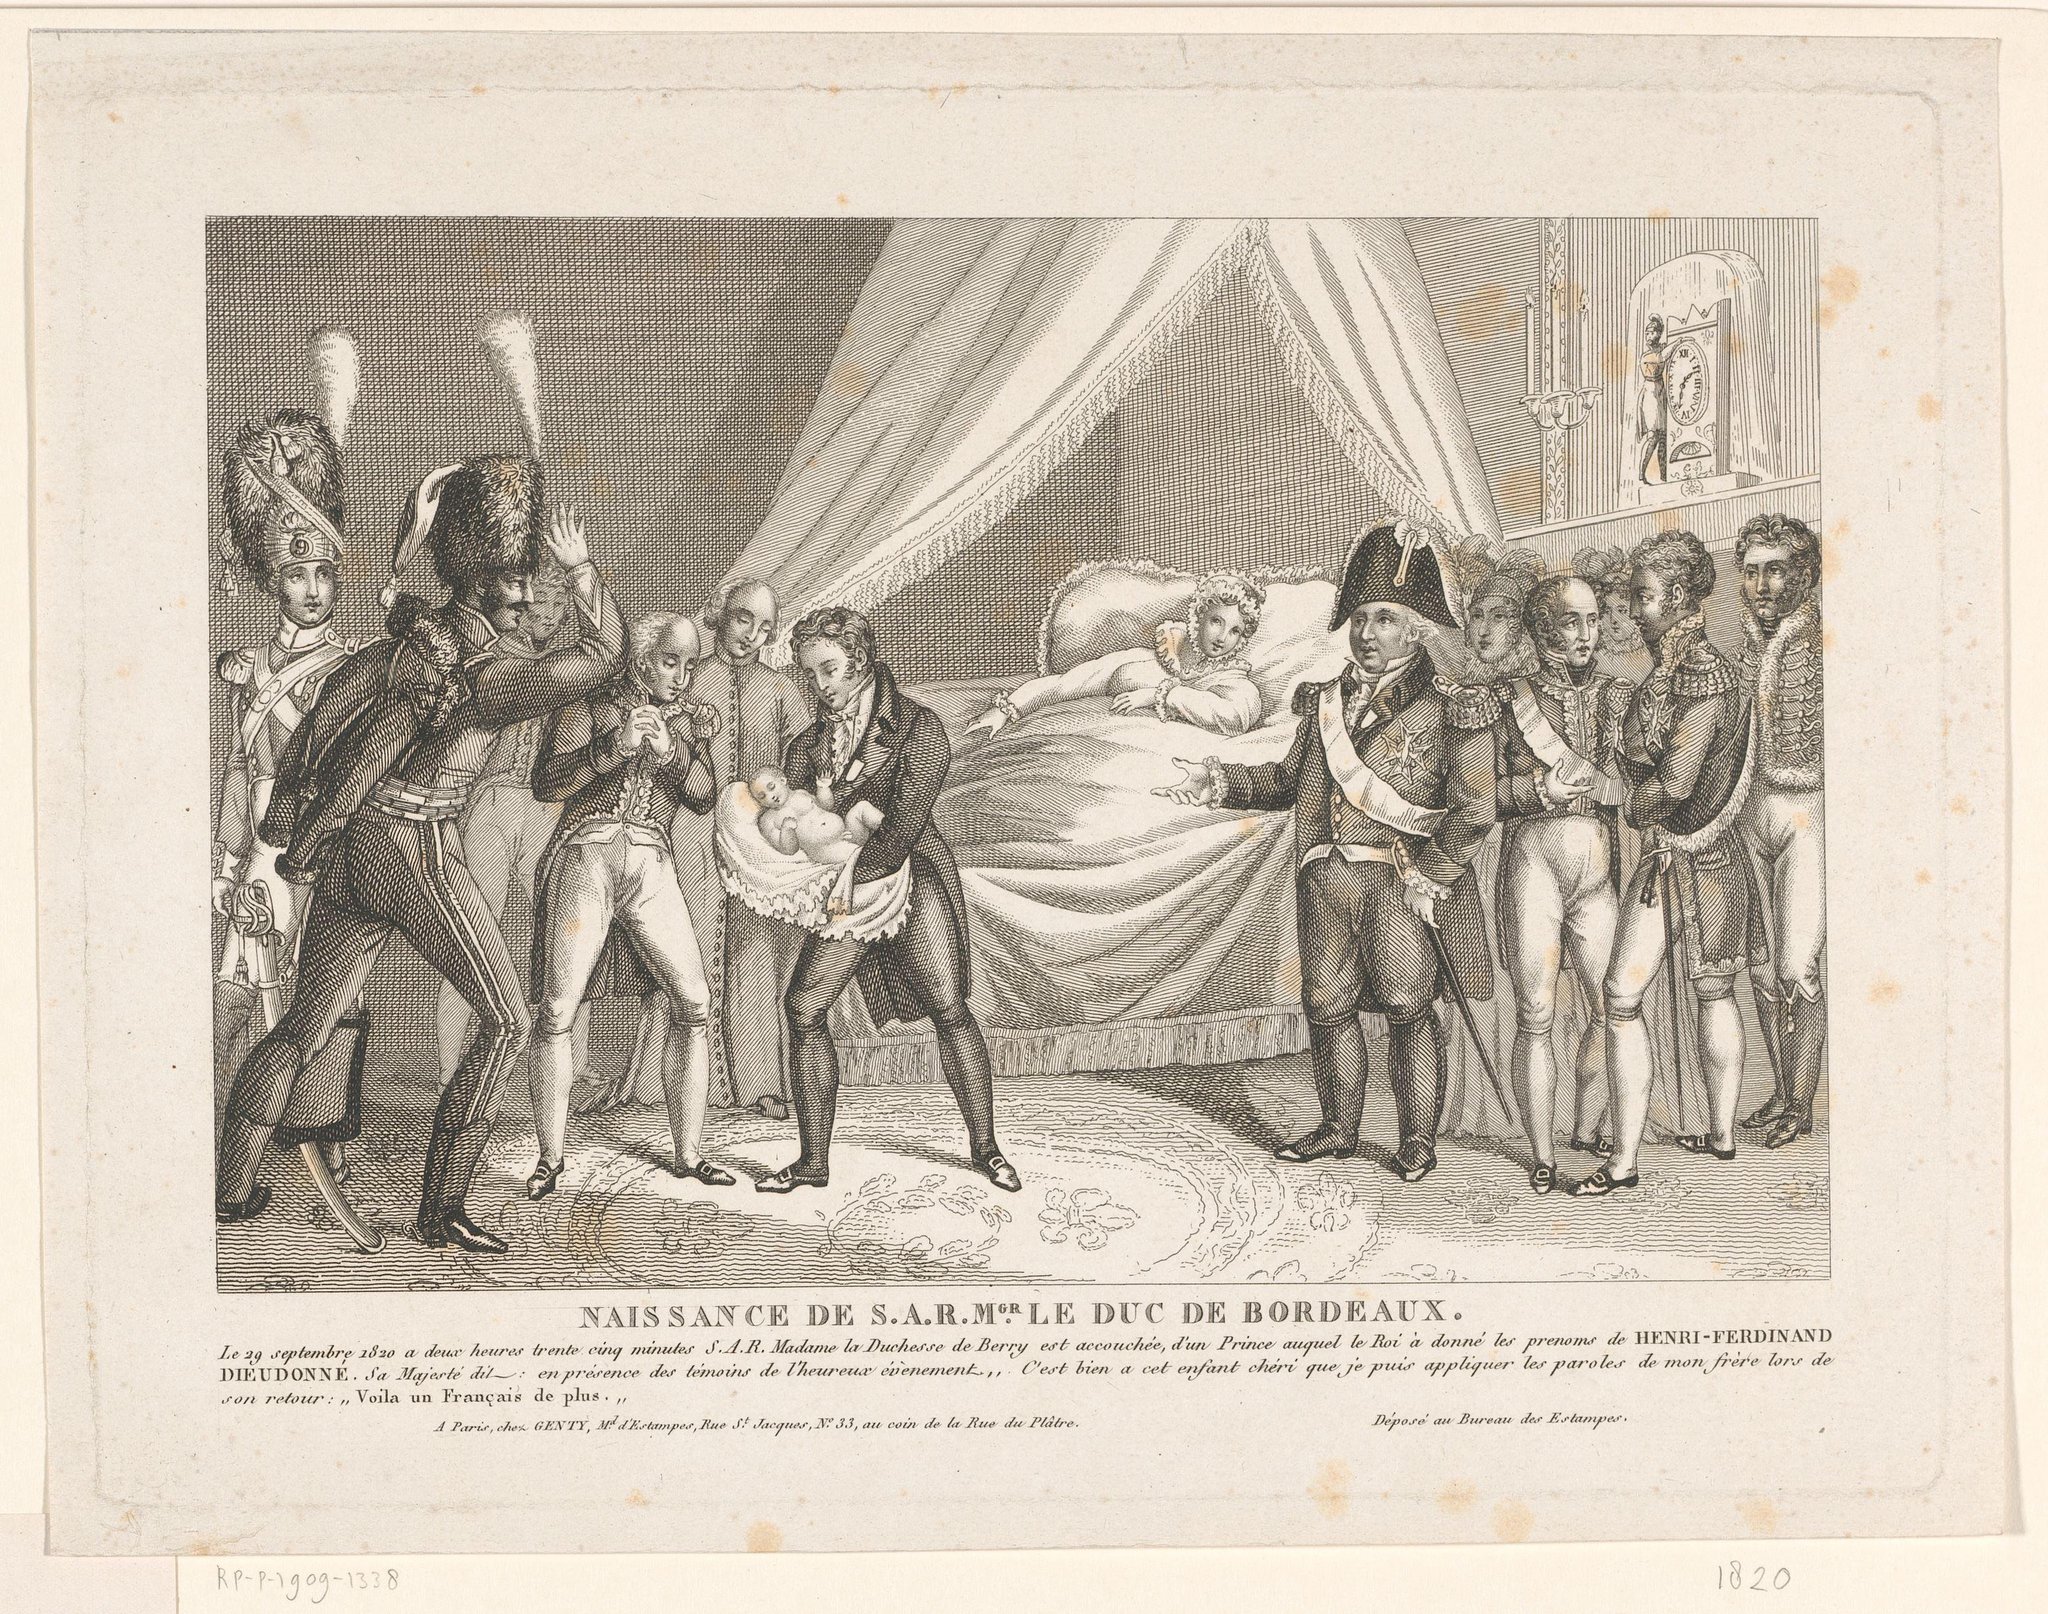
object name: print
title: Geboorte van Henri d'Artois, 1820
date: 1820-1825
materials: paper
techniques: etching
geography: france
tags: visiting the new mother, lying-in visit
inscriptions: collector's mark: Lugt 2228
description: Geboorte van Henri-Ferdinand-Dieudonné duc de Bordeau (ook wel bekend als Henri d'Artois of Hendrik van Artois Bourbon (graaf van Chambord), pretendent naar de Franse troon als koning Hendrik V), 29 september 1820. Kraamkamer met de moeder Maria Carolina van Bourbon-Sicilië in bed, leden van de familie en het hof op kraambezoek.